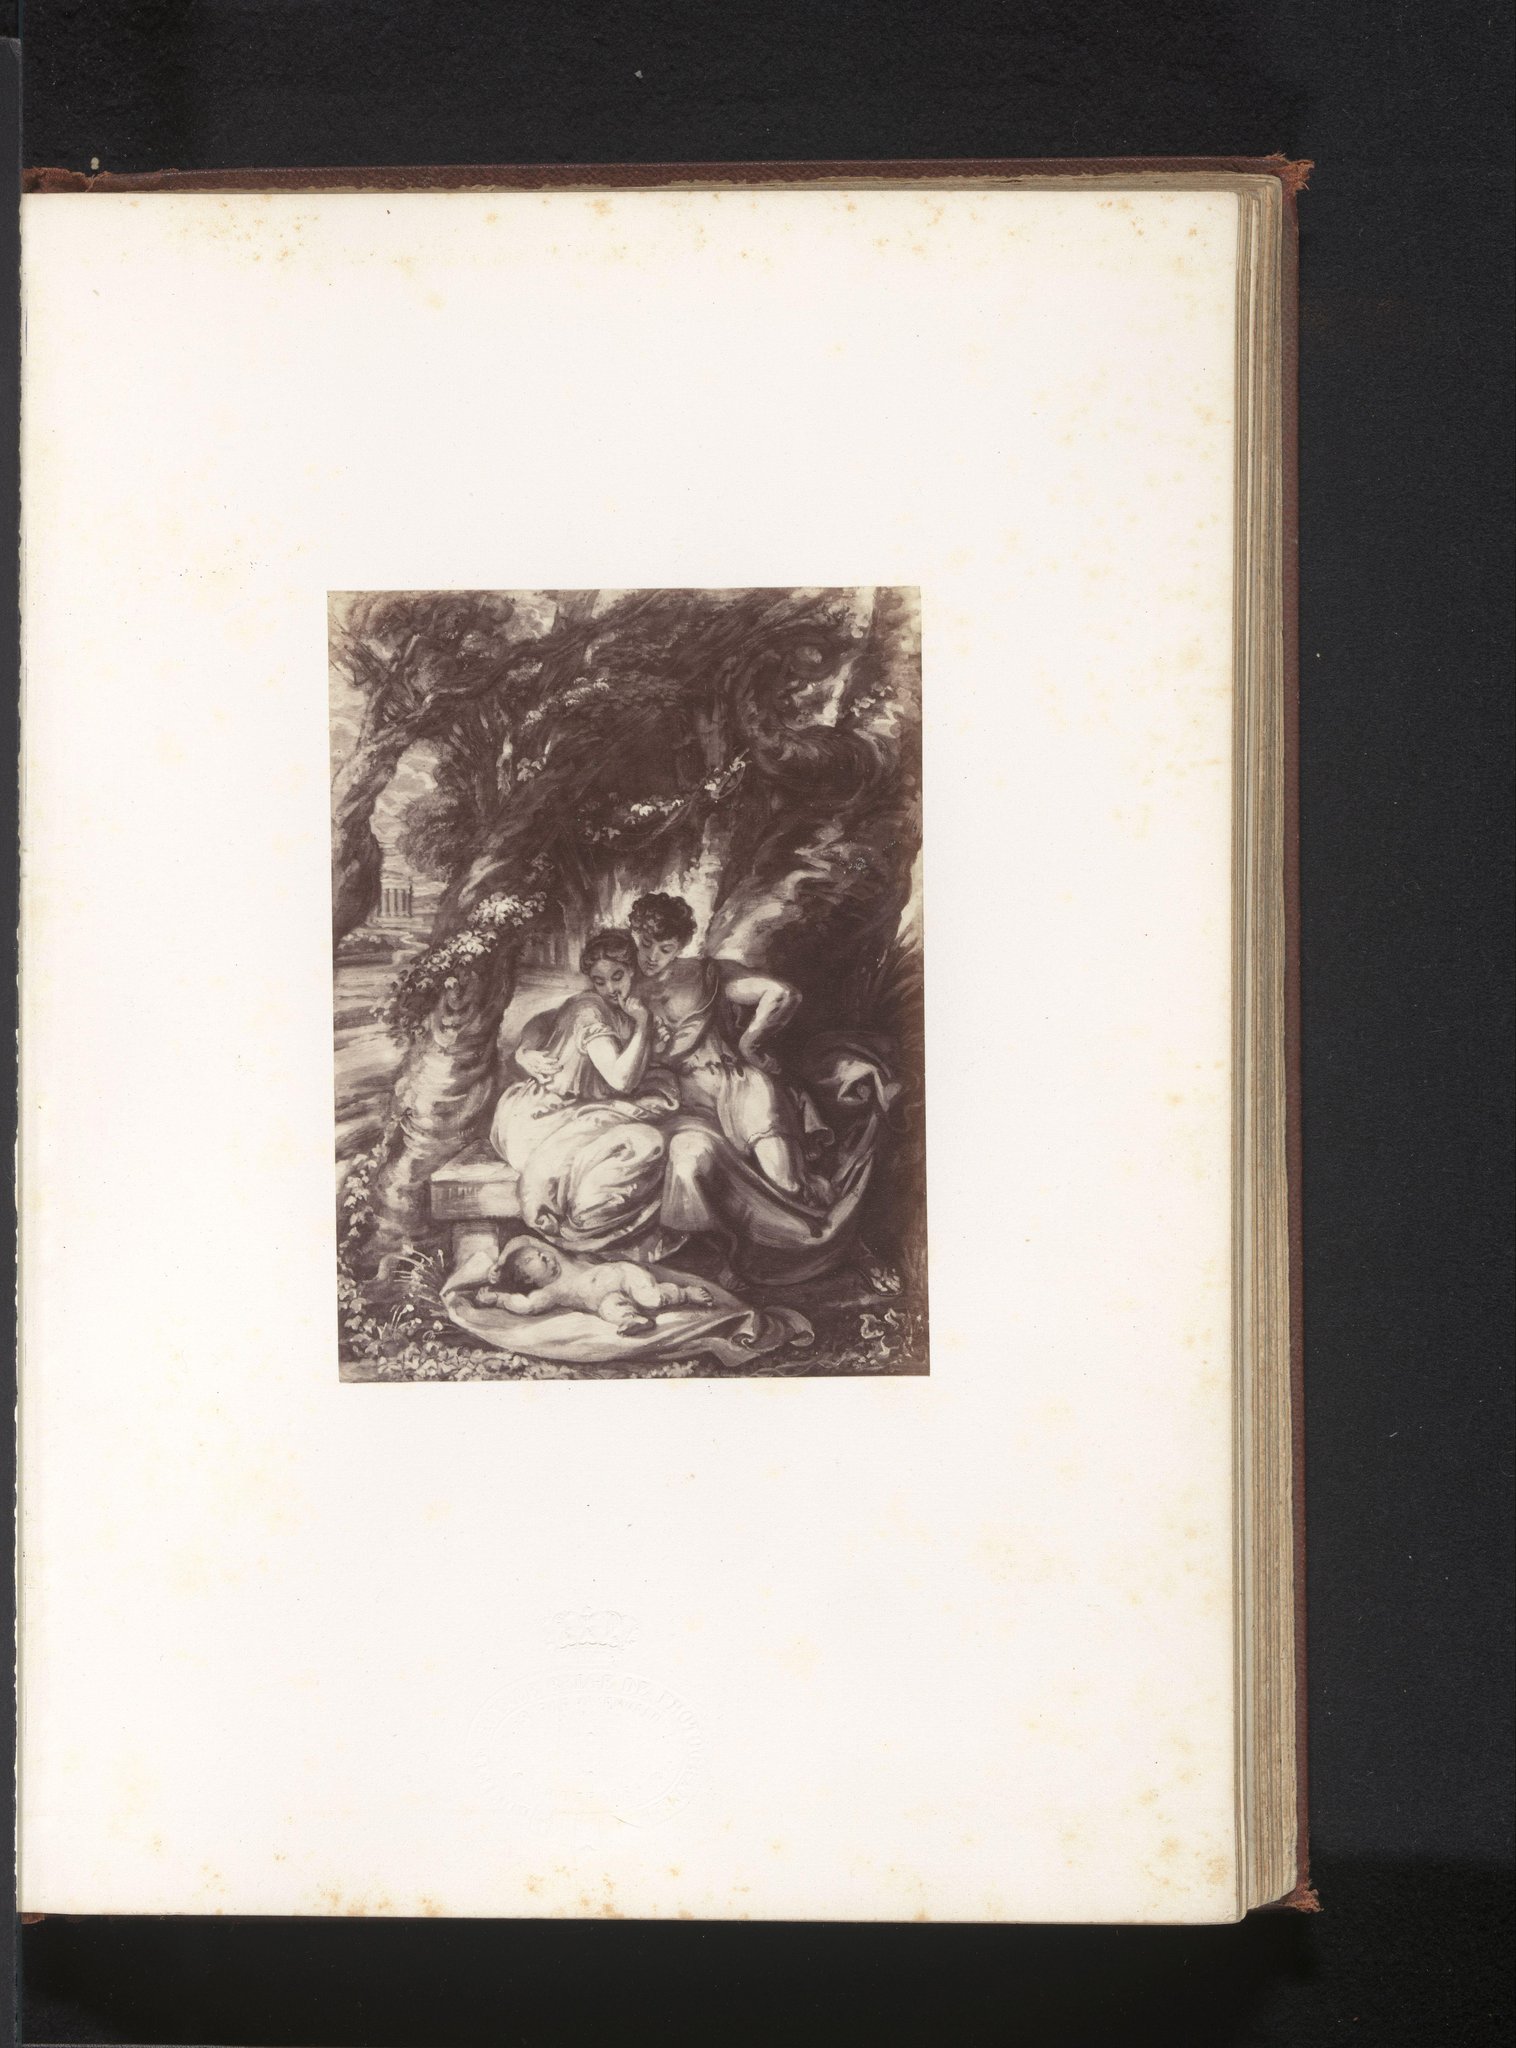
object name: reproduction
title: Fotoreproductie van In familie III: Het kind door Antoine Wiertz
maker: edmond fierlants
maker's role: fotograaf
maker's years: 1819-1869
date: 1863-1868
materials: photographic support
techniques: albumen print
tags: parents with their children, watching a sleeping child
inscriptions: check stamp: ‘SOCIÉTÉ ROYALE BELGE DE PHOTOGRAPHIE/ 69, RUE KEYENVELD/ BRUXELLES’